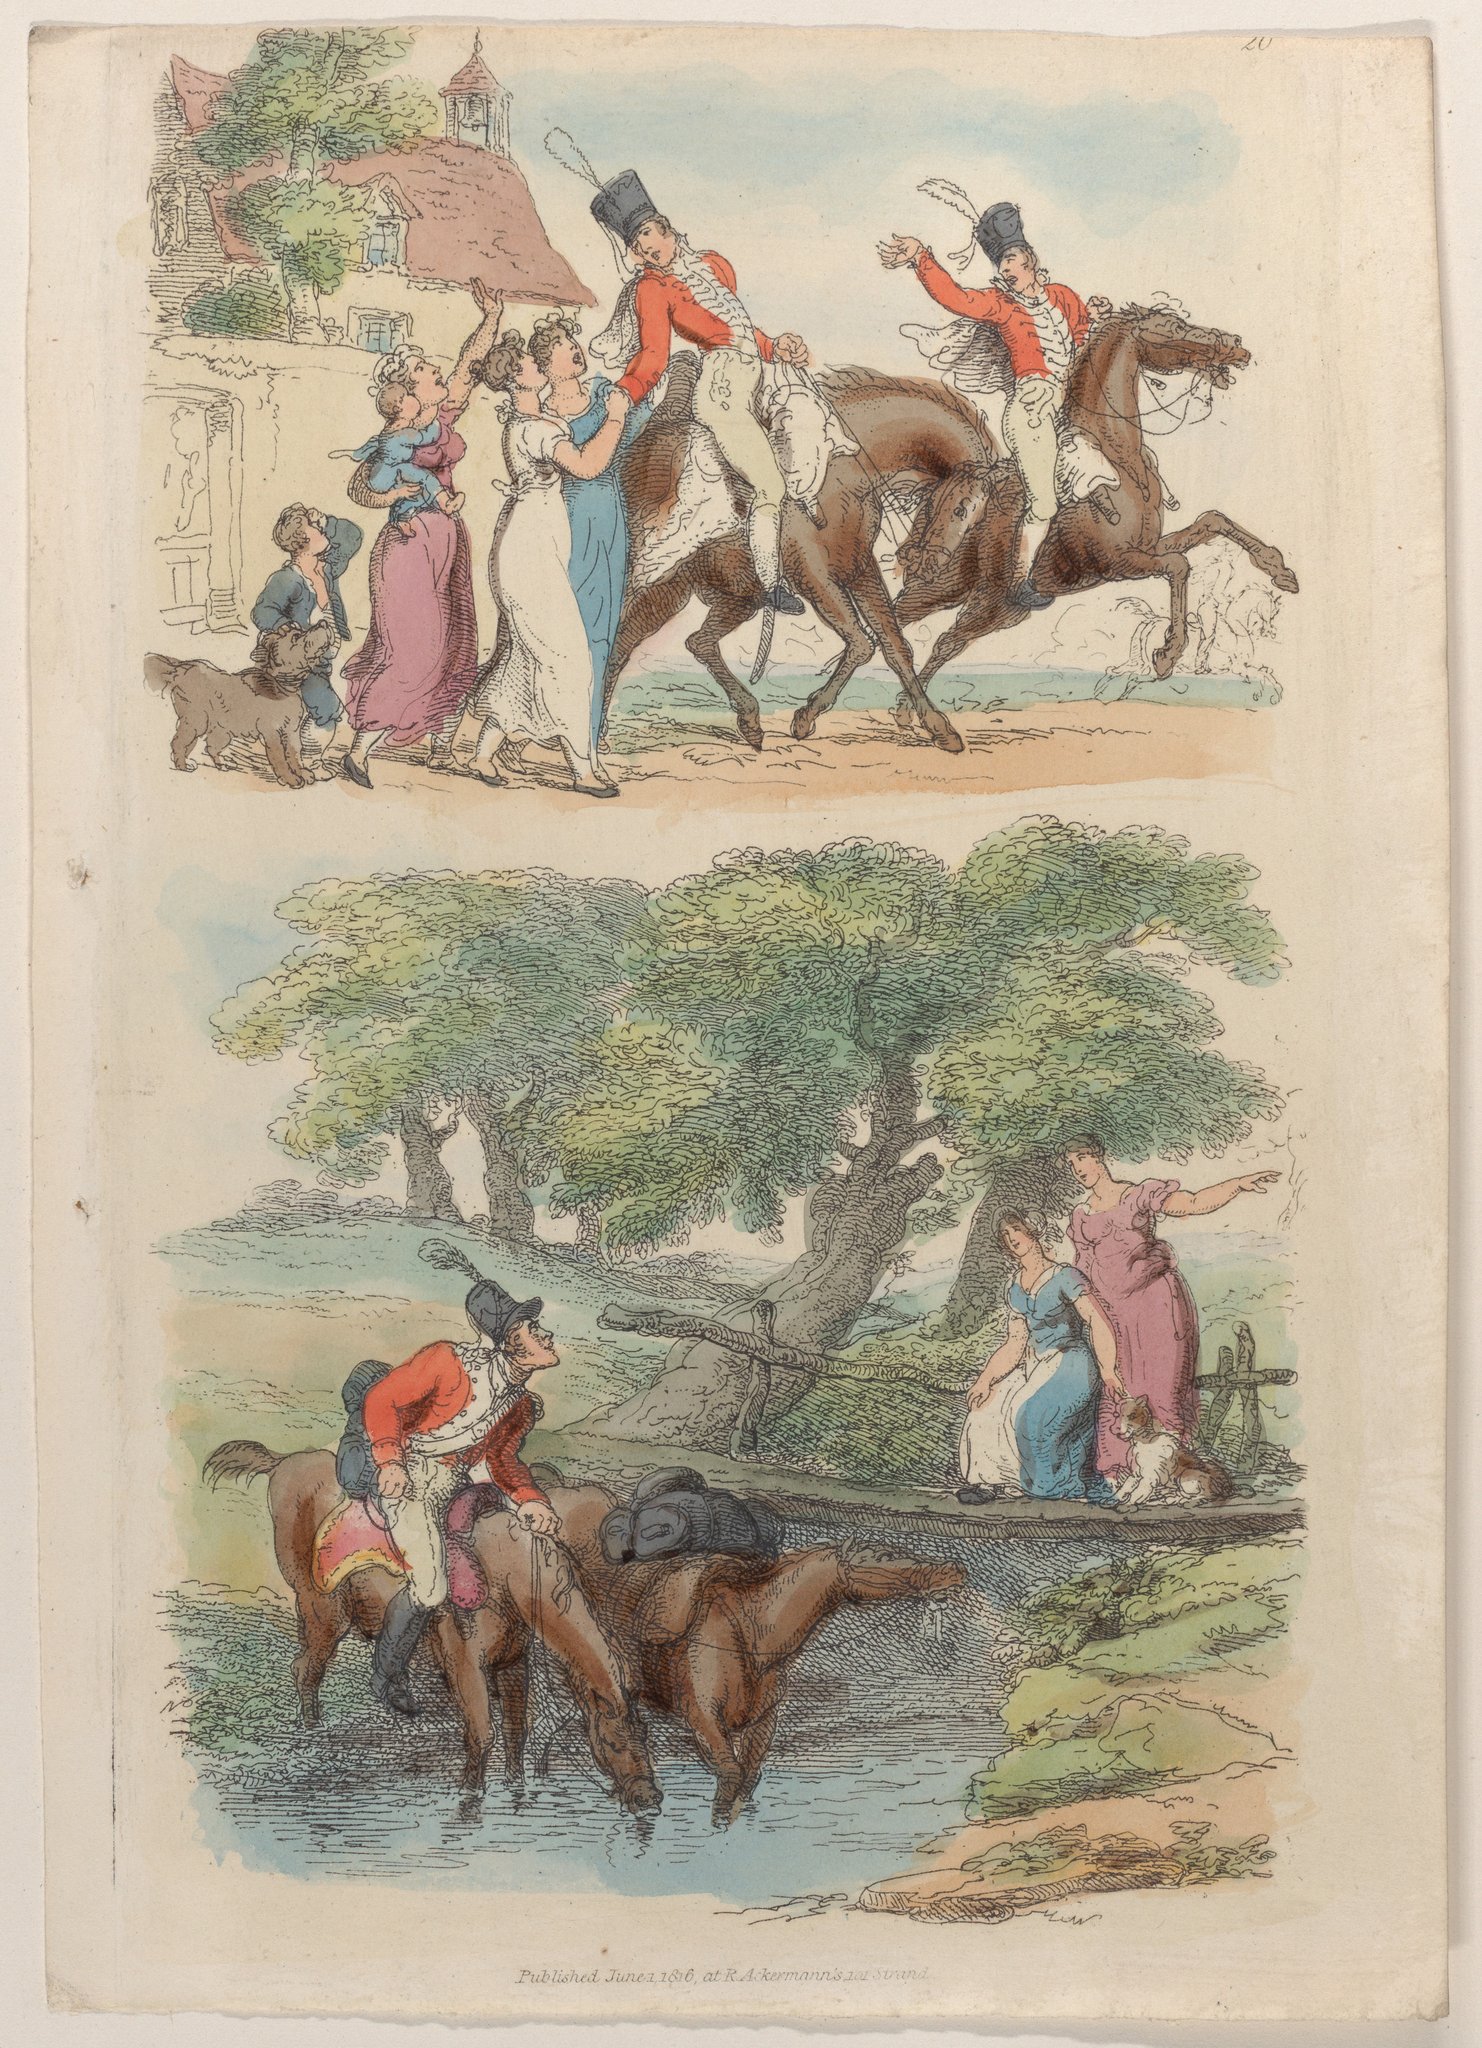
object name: print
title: Plate 20, from "World in Miniature"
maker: thomas rowlandson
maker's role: artist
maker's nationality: british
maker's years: 1757-1827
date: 1816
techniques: etching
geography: london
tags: soldiers,men,women,dogs,horses